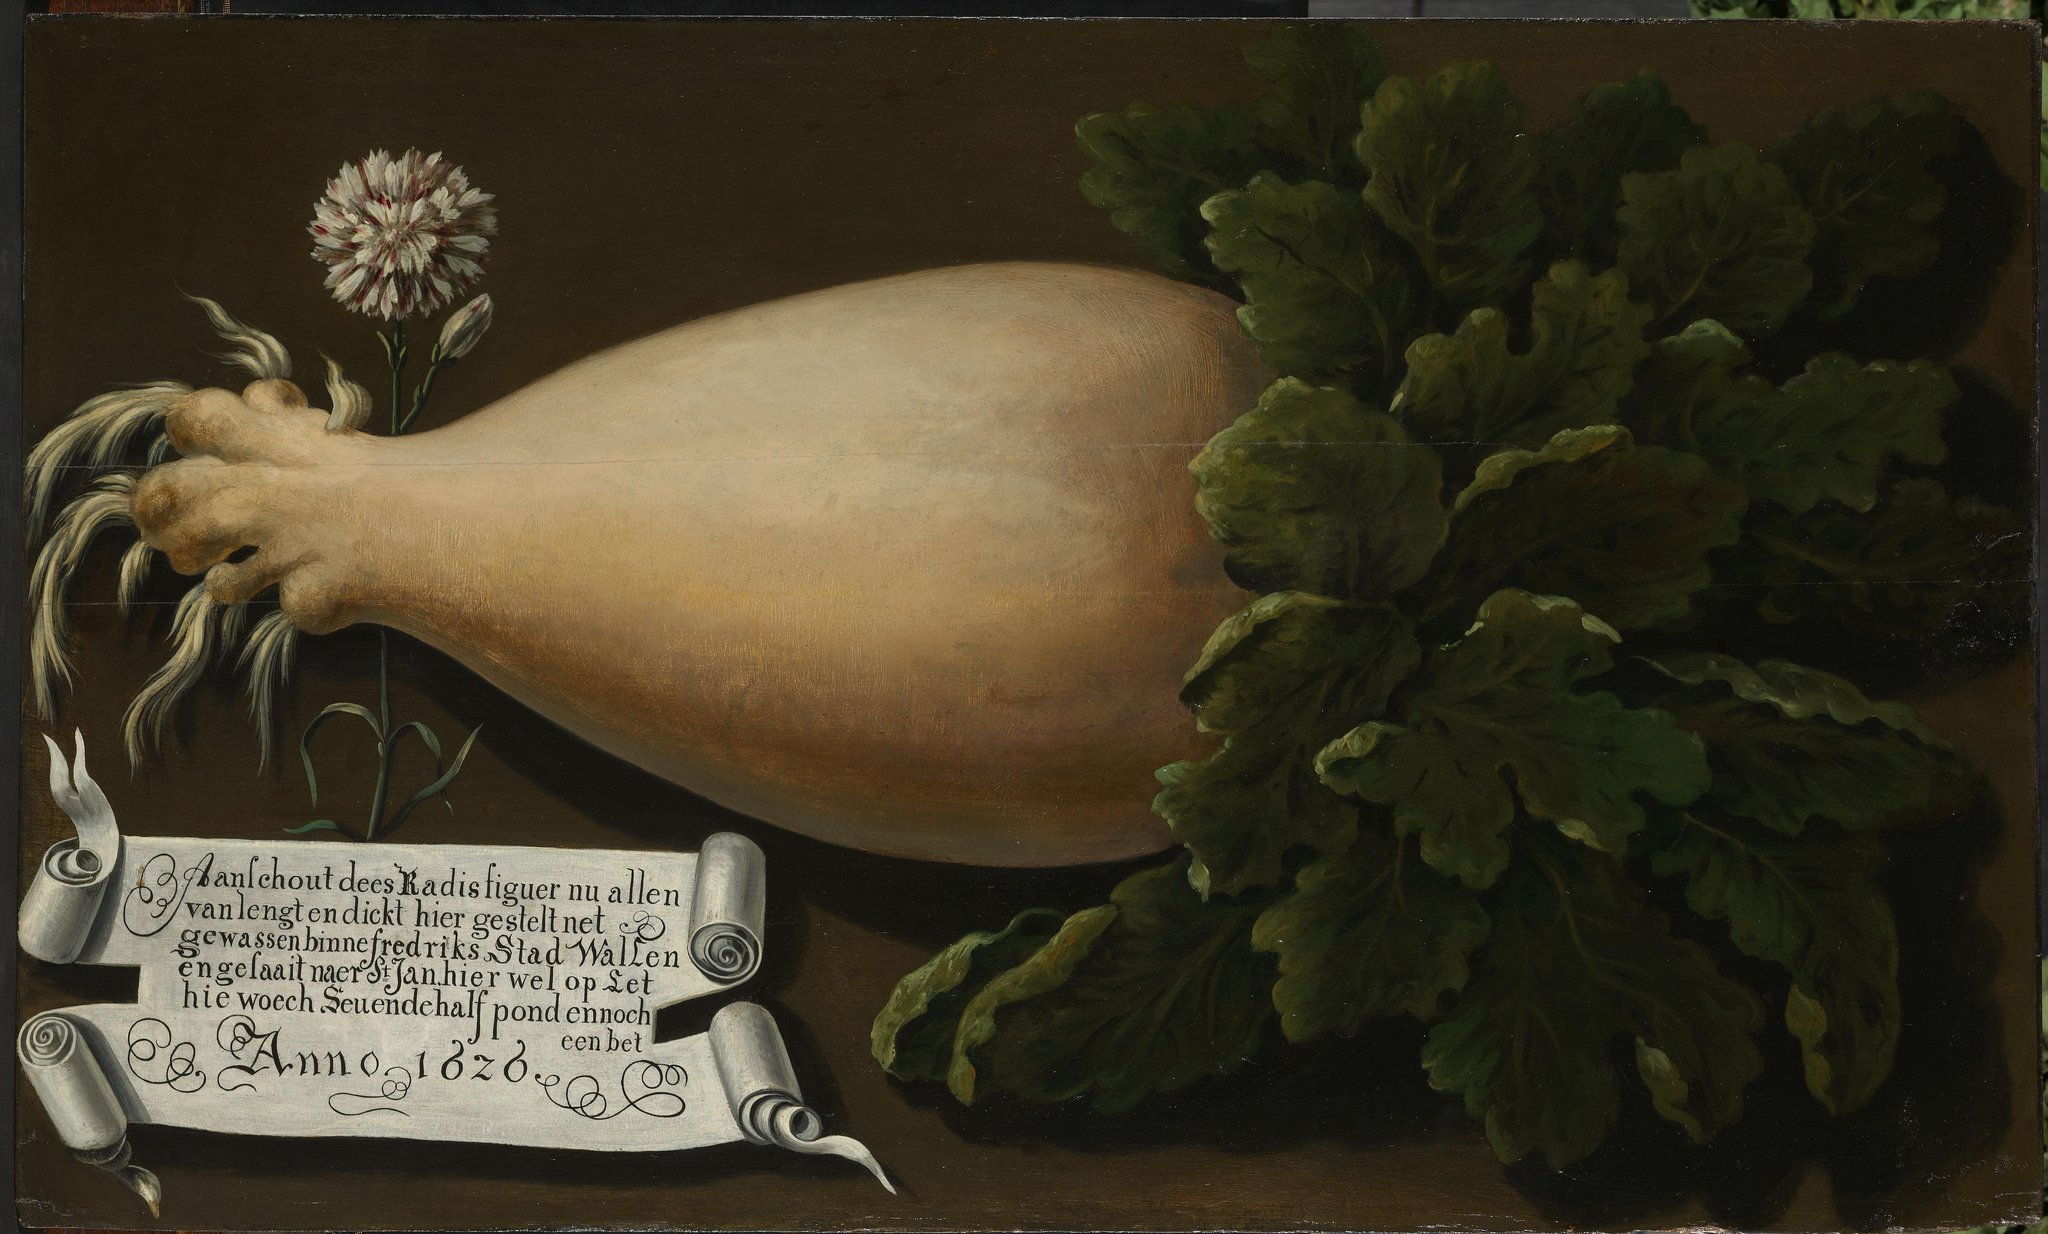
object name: painting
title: A Giant Radish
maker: Anonymous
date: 1626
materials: oil, paint, panel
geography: northern netherlands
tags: (non-fruit) products of plants or trees: radish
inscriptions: inscription and date: ‘Aanschout dees Radisfiguer nu allen van lengt en dicht hier gestelt net gewassen binne fredriks Stad Wallen en gesaait naer St. Jan. hier wel op let hie woech Sevendehalf pond en noch en bet. Anno 1626’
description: Een reuzenradijs, met een gewicht van meer dan zeven en een half pond. Links een inscriptie op een blad papier en een anjer.